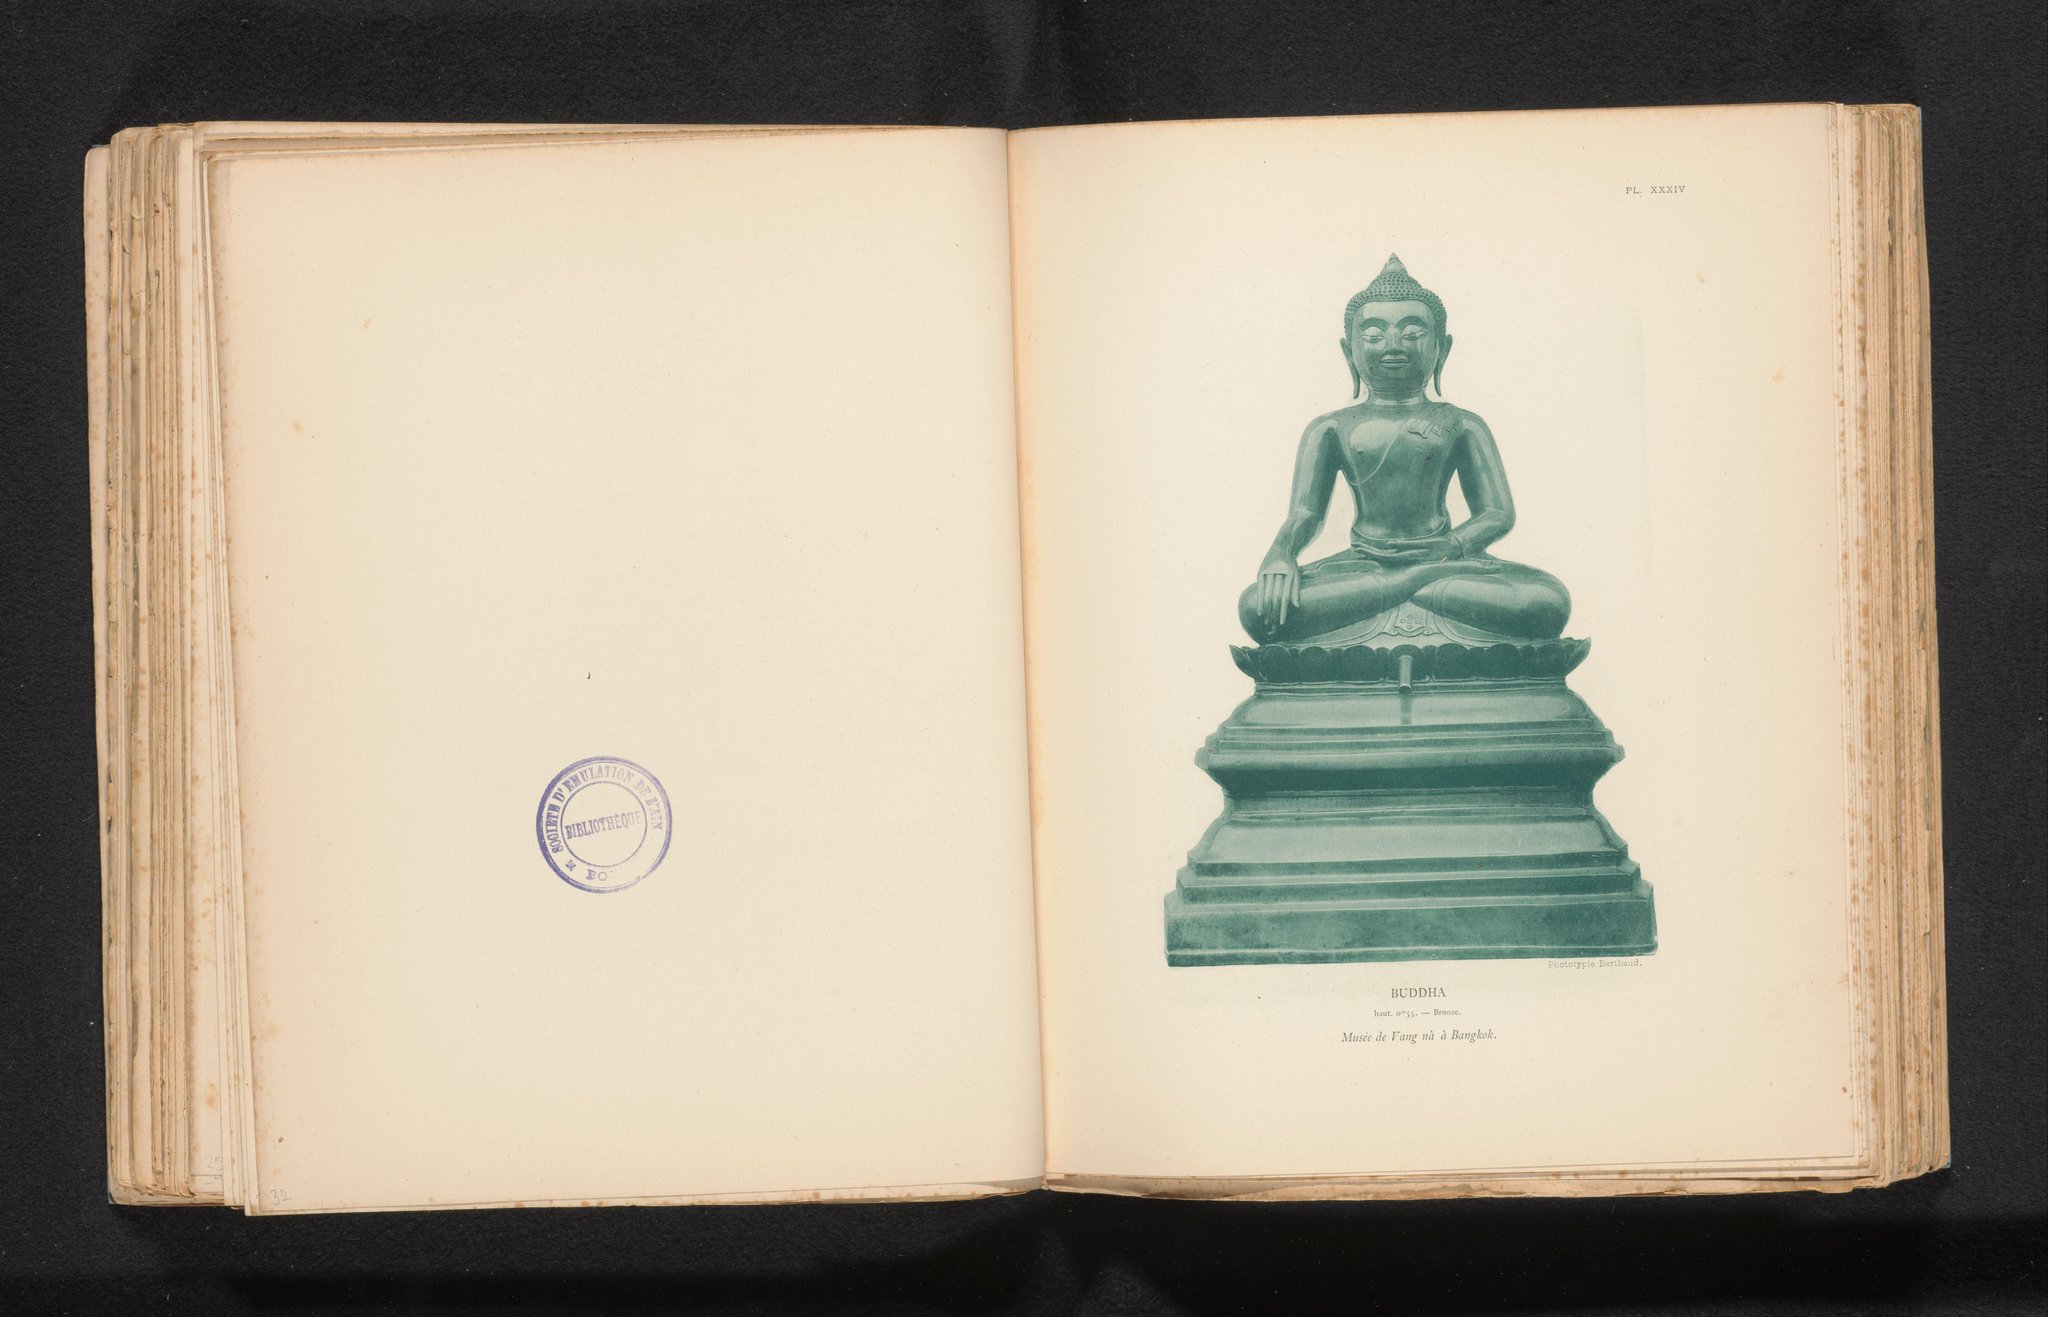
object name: page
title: Sculptuur van Boeddha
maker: michel berthaud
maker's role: publisher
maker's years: 1845-1912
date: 1890-1895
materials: paper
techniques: photograph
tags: representations ~ gods, demi-gods, heroes, etc. (hinduism, buddhism, jainism)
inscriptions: inscription: ‘hauteur 0m55 - Bronze/ Musée de Vang nà, à Bangkok’, collector's mark: ‘Société d'Emulation de l'Ain/ Bourg/ Bibliothèque’, inscription: ‘Pl. XXXIV’